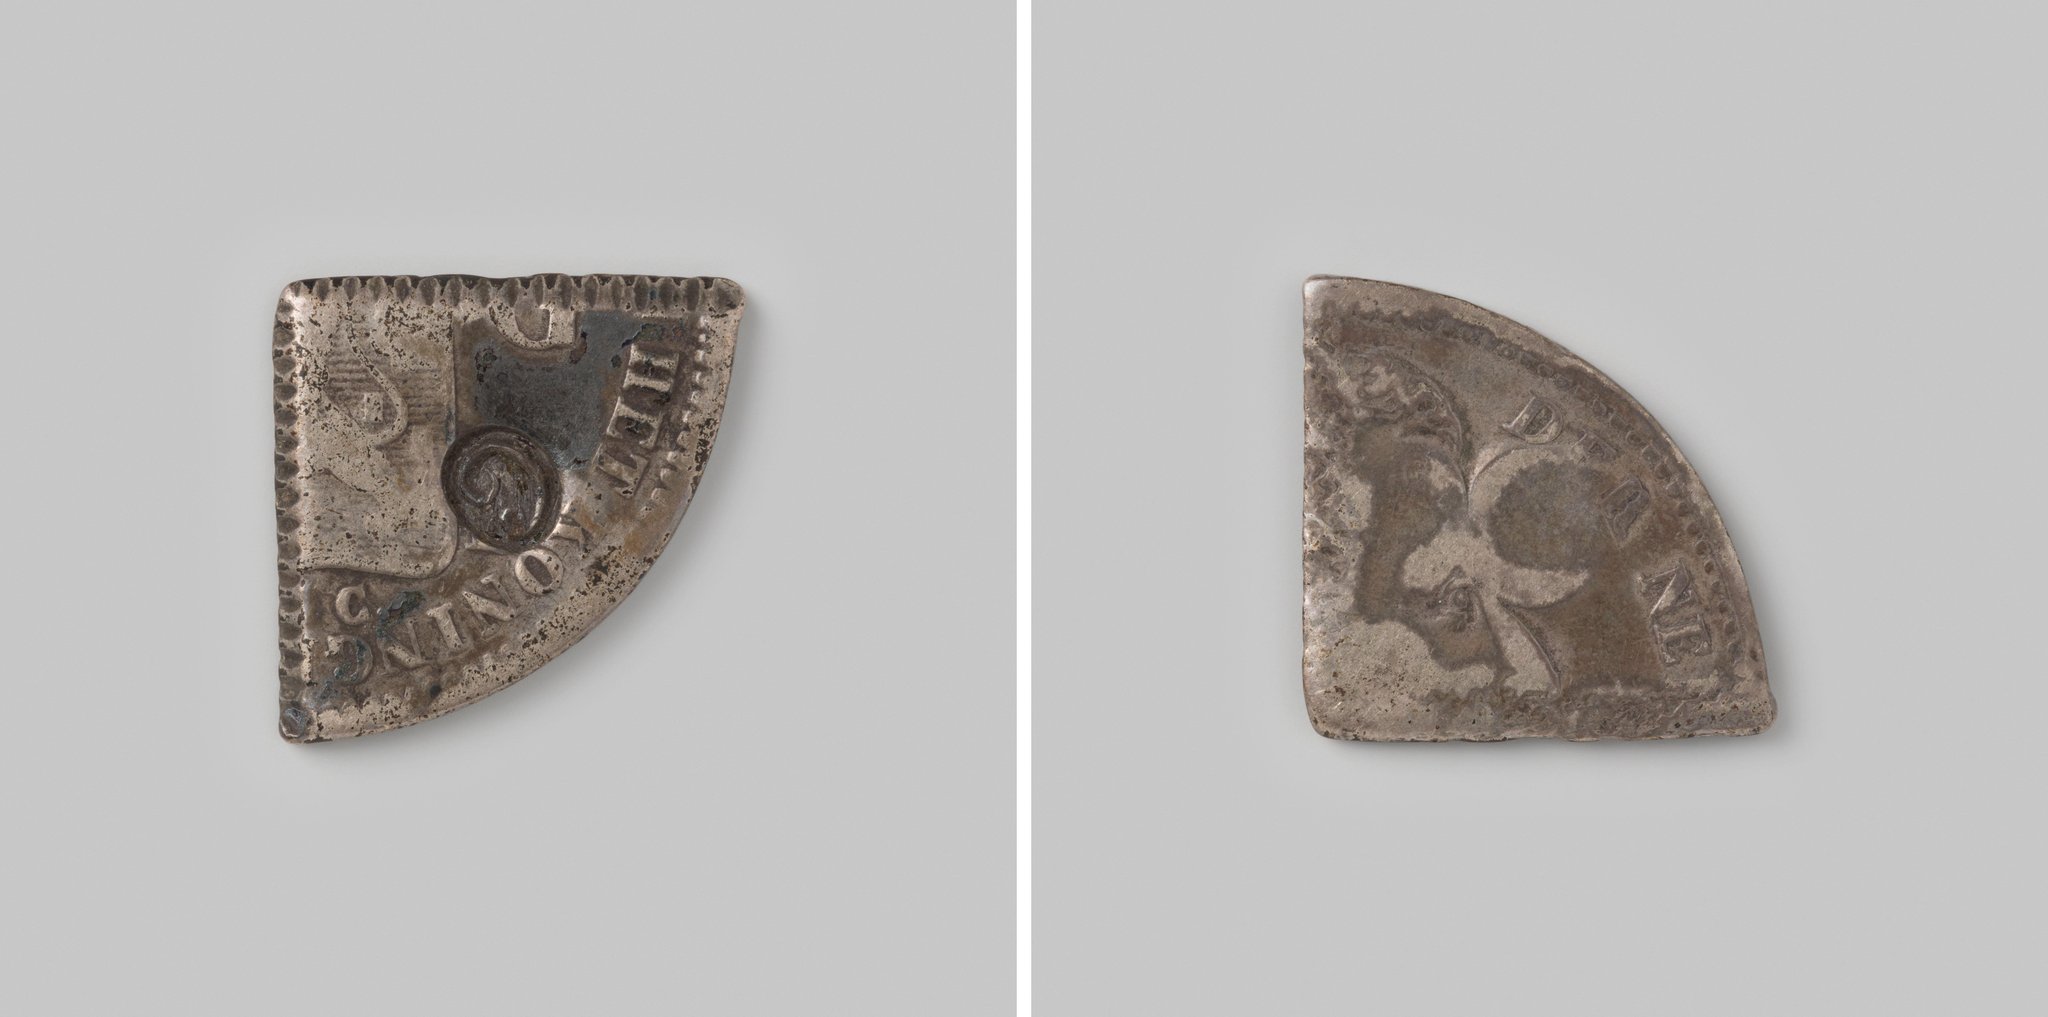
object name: coin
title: Driekantje van 25 cent uit een Nederlandse gulden van Willem I voor Curacao, [1838]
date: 1838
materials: silver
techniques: striking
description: Zilveren munt, een vierde gedeelte van een in vier delen gekapte Nederlandse gulden van Willem I, zogenaamd driekantje. Voorzijde: gedeelte van het gekroonde Nederlandse wapenschild. Keerzijde: gedeelte van het hoofd van Willem I naar rechts. Op voorzijde of keerzijde gestempeld, geklopt: letter C. Randschrift en kartelrand.